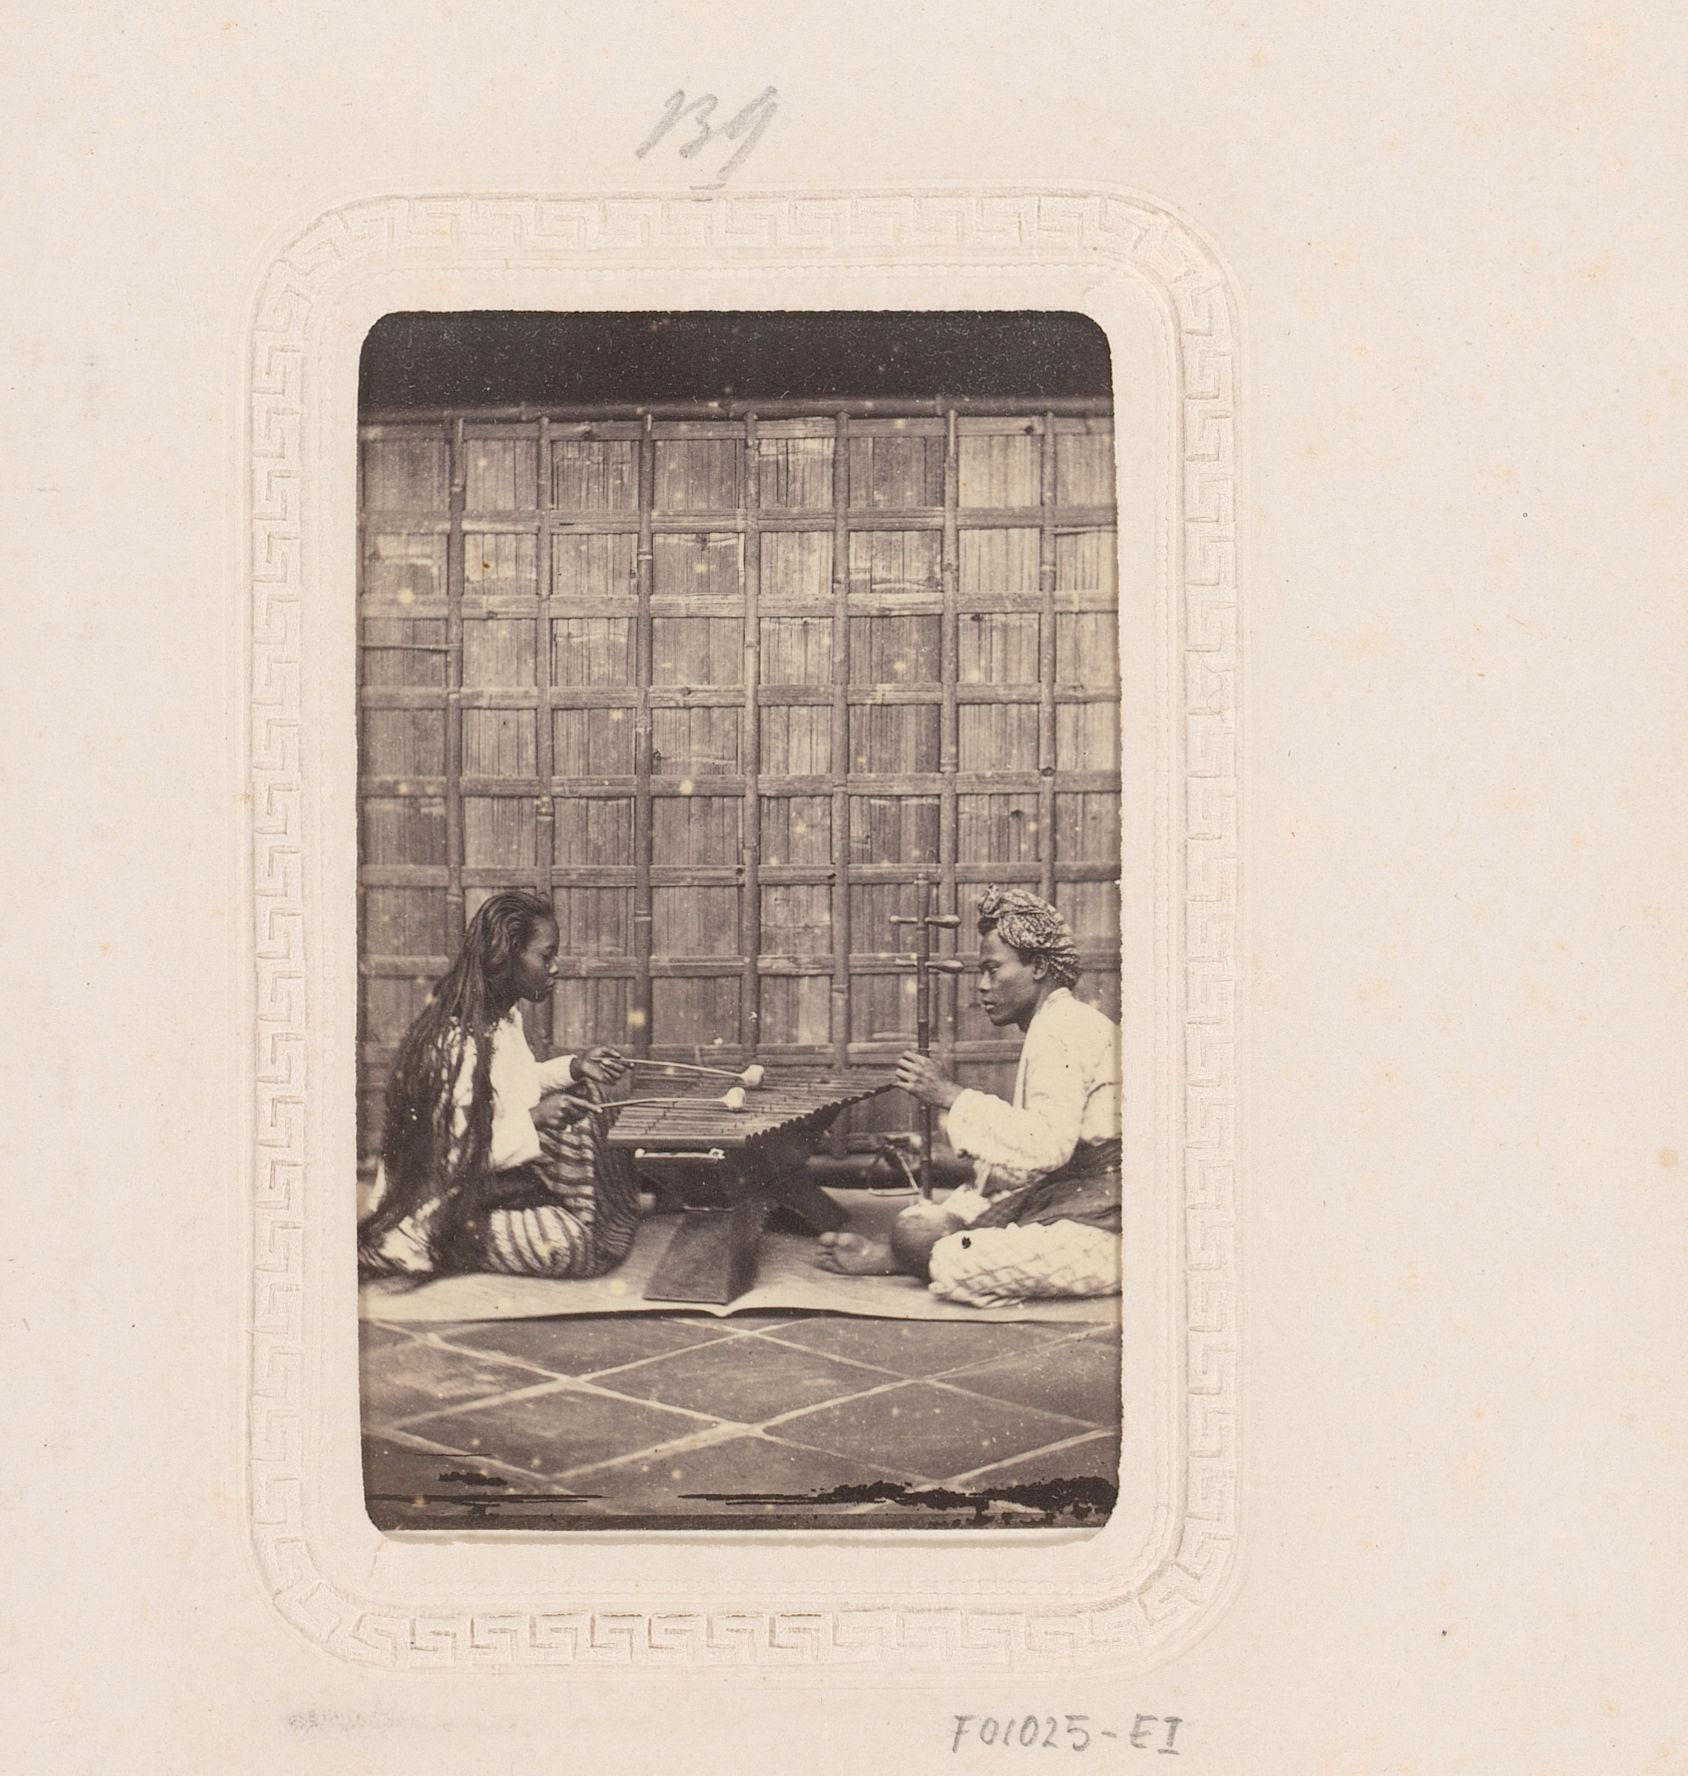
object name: album leaf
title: Indonesische vrouw en man met muziekinstrumenten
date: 1857-1880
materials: cardboard, photographic support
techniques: albumen print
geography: java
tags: musical instruments; group of musical instruments, musician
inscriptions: inscription: ‘Woodbury & Page/ Photographers/ Java’, number: ‘139’